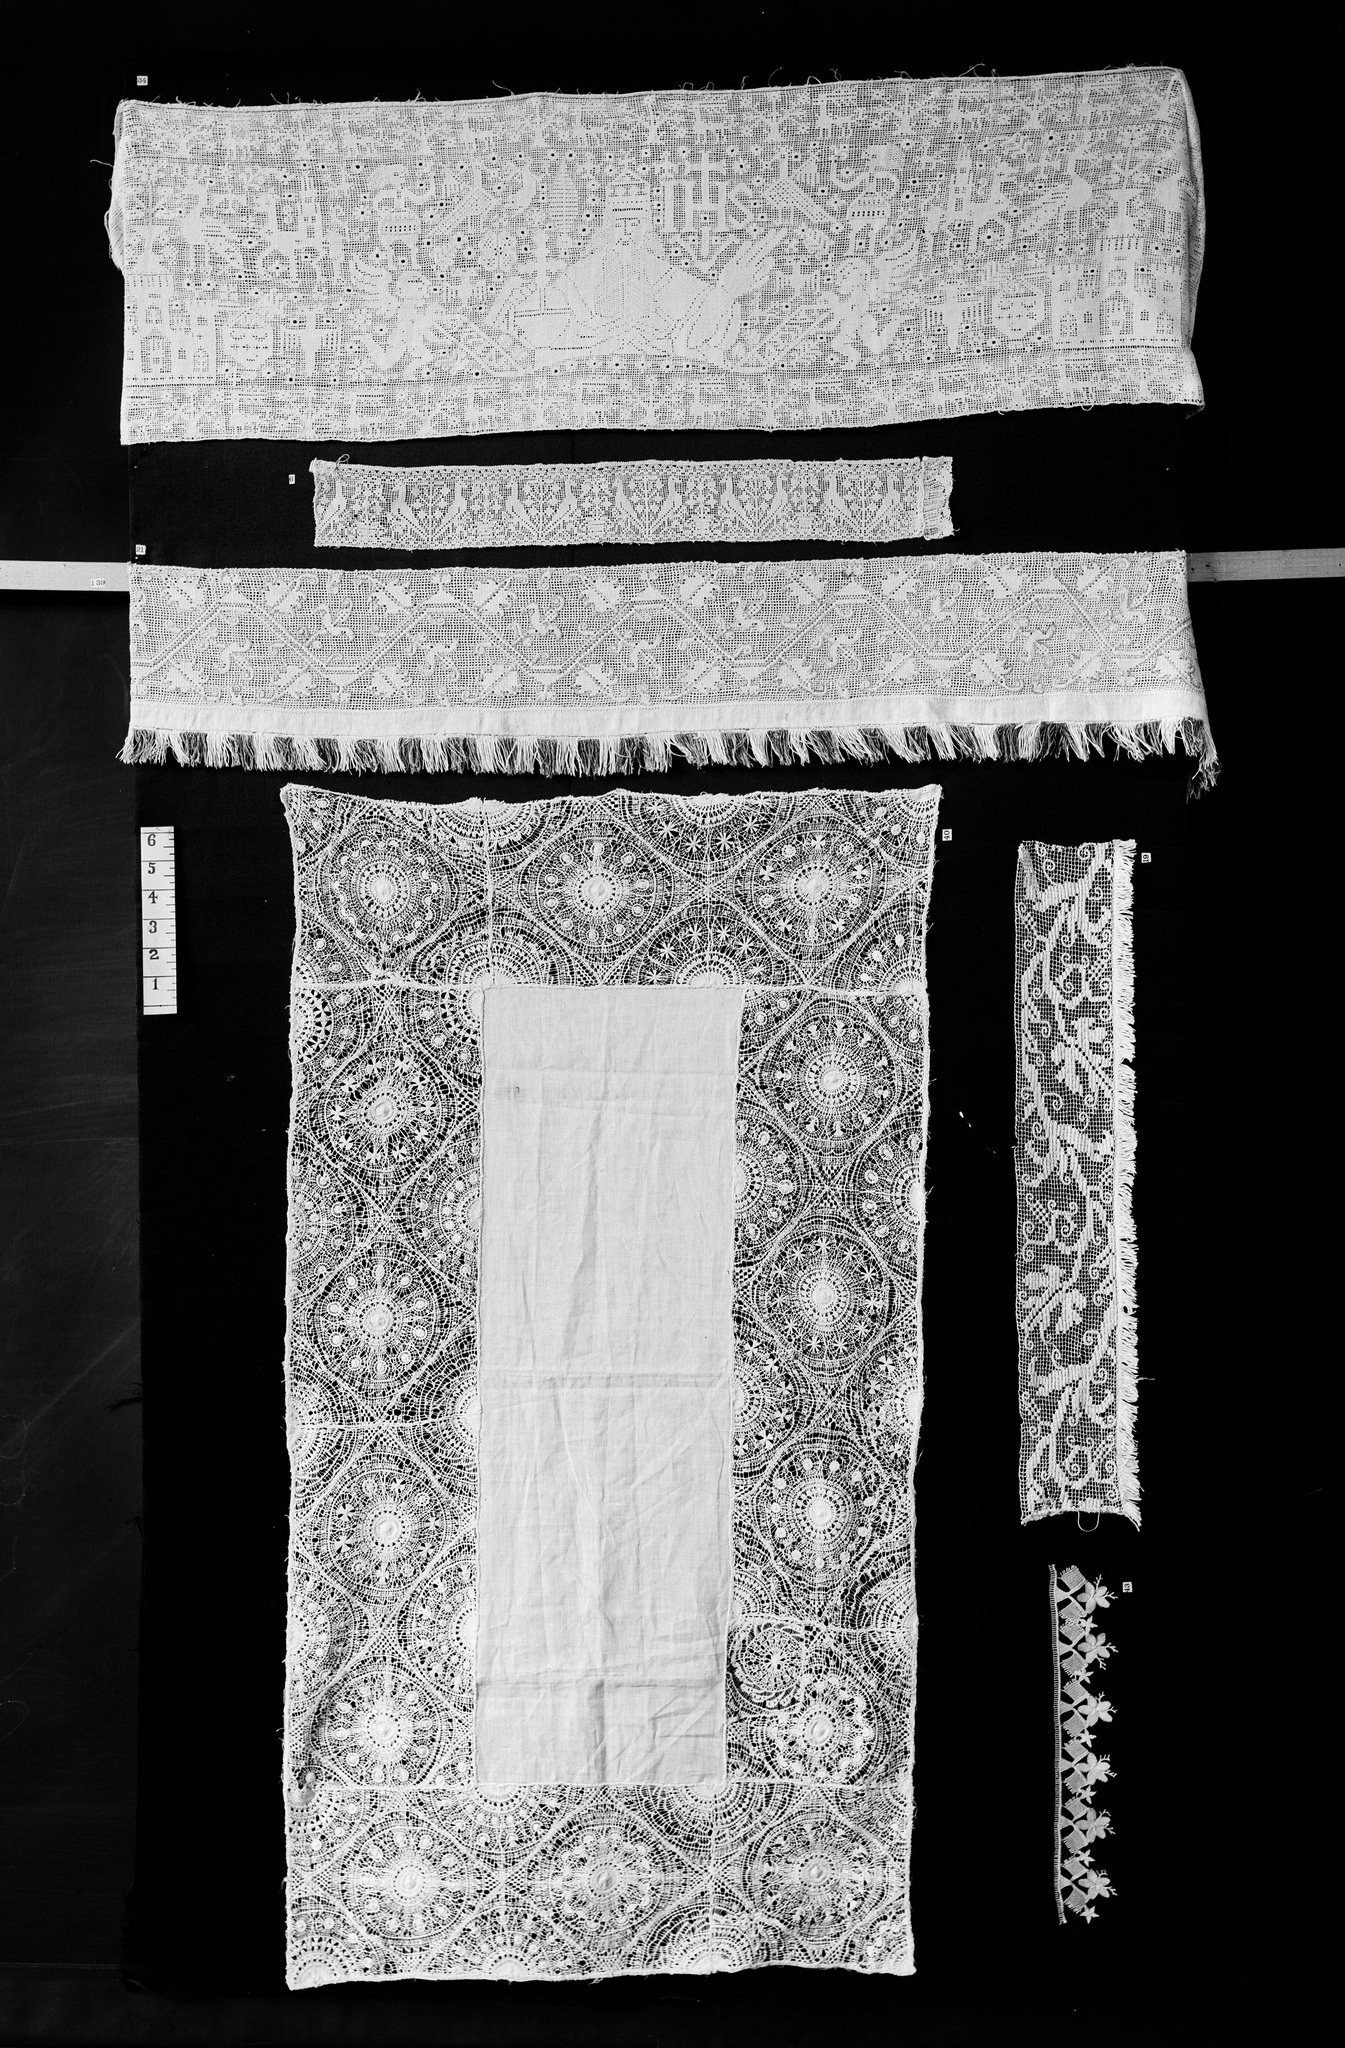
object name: cover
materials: linen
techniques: embroidery